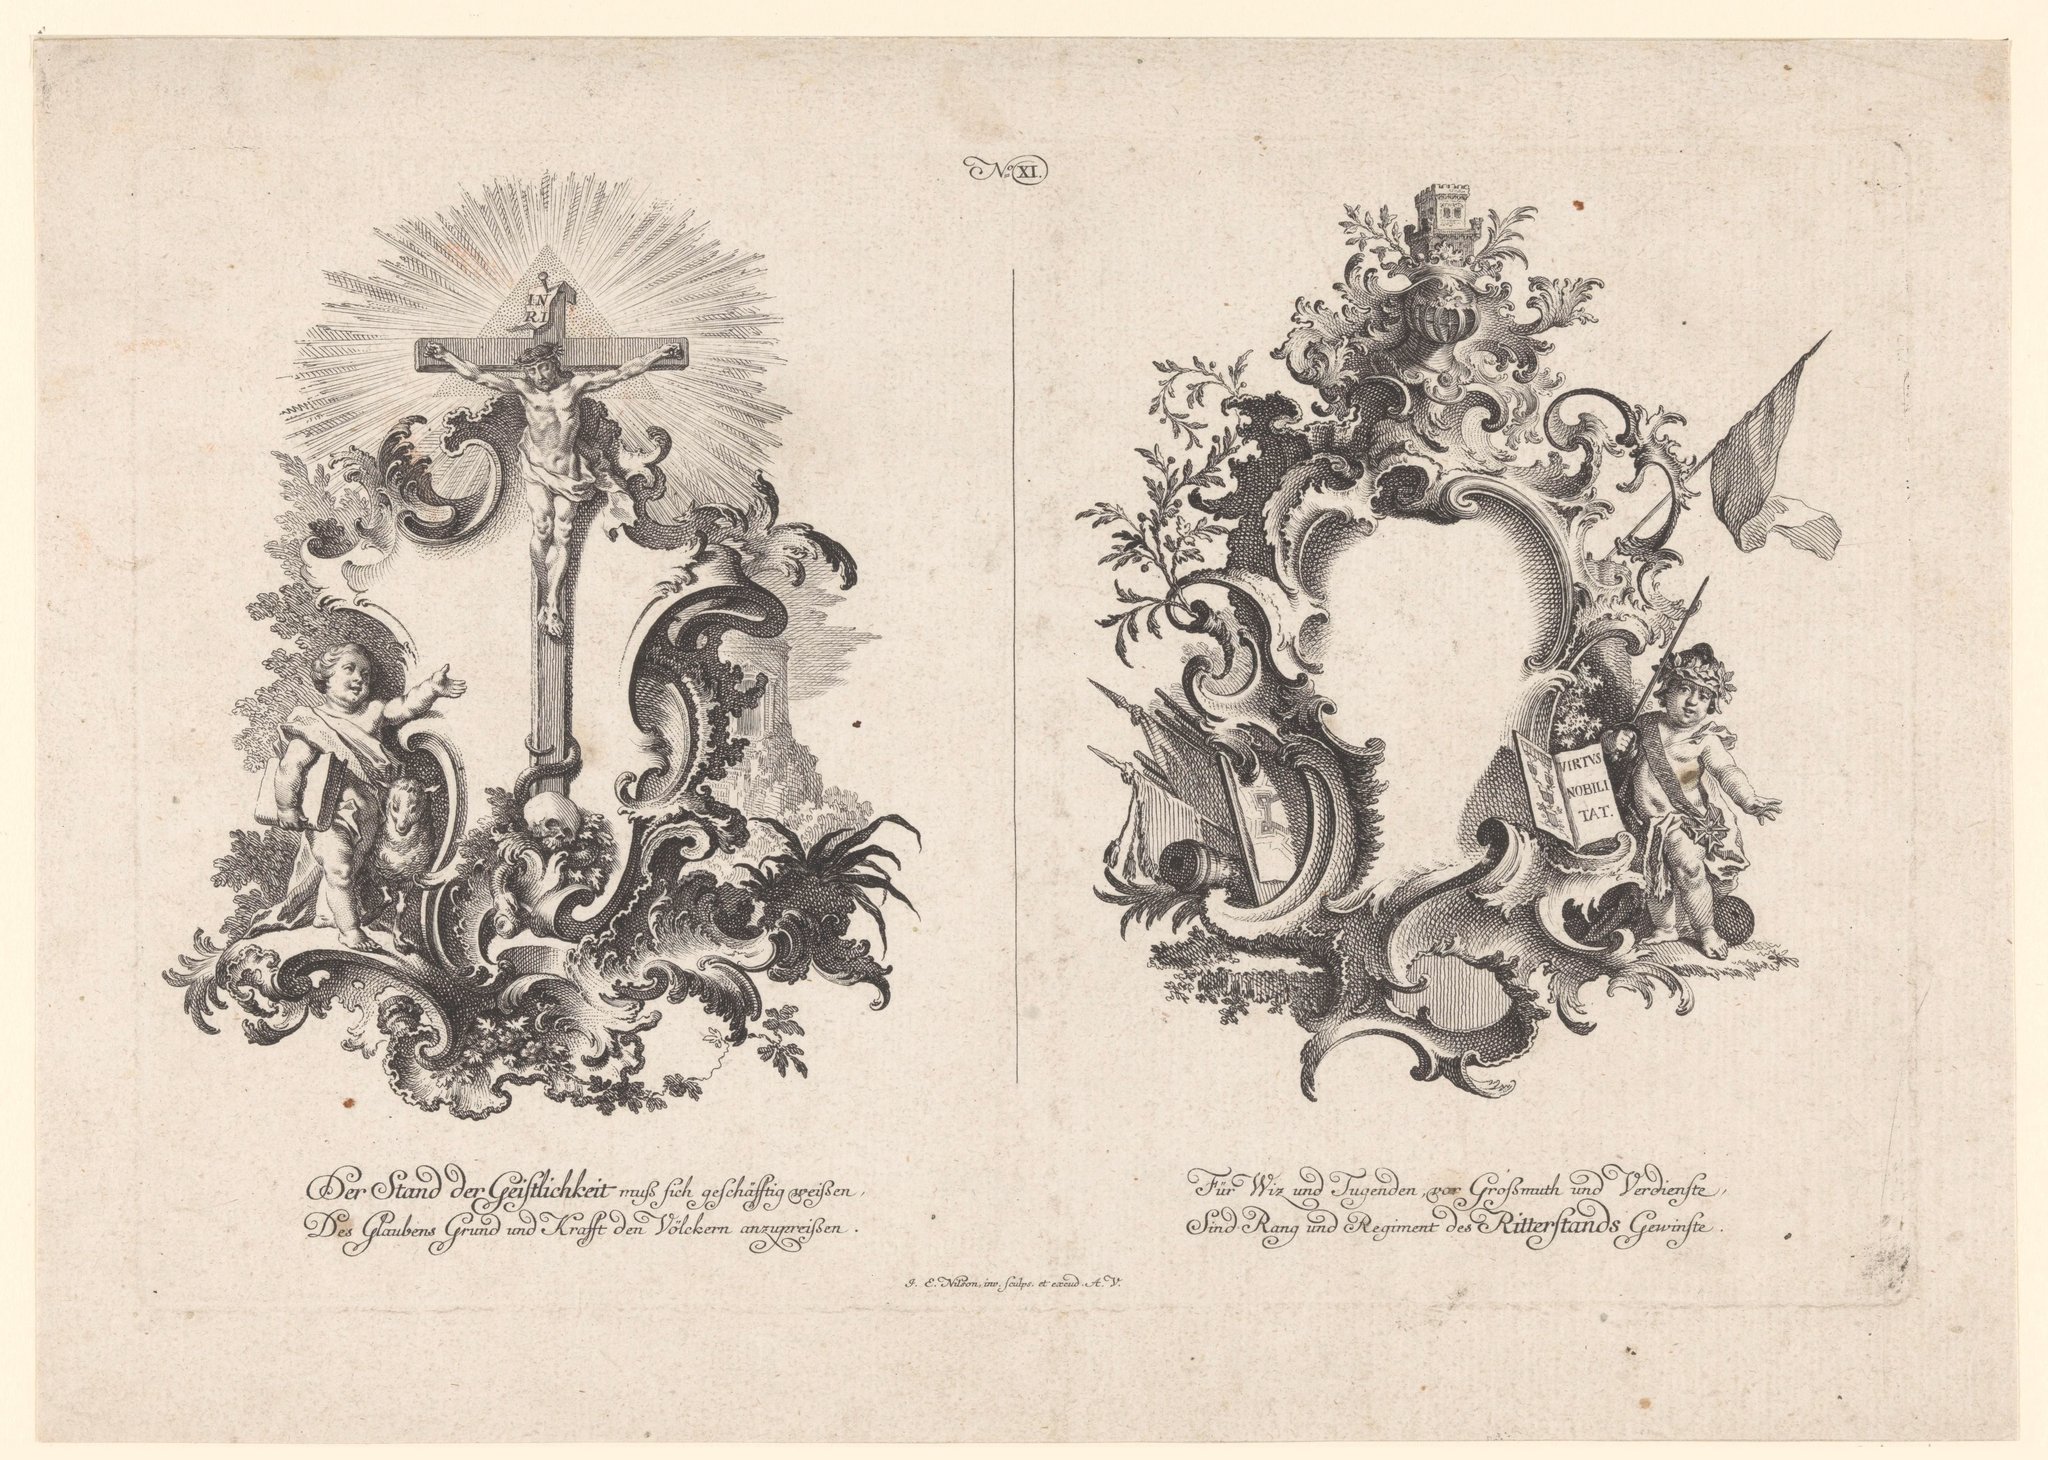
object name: print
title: Geestelijkheid en ridderstand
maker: johann esaias nilson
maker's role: draughtsman, print maker, publisher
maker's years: 1721-1788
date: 1731-1788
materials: paper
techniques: engraving, etching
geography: augsburg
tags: ornament ~ cartouche, organization, functionaries and dignitaries in roman catholic church; clergy in general, the three estates: nobility, clergy, commoners, nobility and patriciate; chivalry, knighthood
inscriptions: collector's mark: Lugt 2228, collector's mark: Lugt 2760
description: Blad met links de geestelijke stand en rechts de ridderstand. Links een rocaille cartouche met Christus aan het kruis met doodshoofd en slang. Aan de bovenzijde een driehoek met stralenkrans. Links staat een putto met een boek en een schaap. Rechts een rocaille cartouche met helm, wapens, kasteeltoren en een vlag. Rechts staat een putto met helm, lans en een ordeband naast een open boek met tekst. In de ondermarge twee kolommen met tweeregelige Duitse tekst. Uitgeversnummer XI.